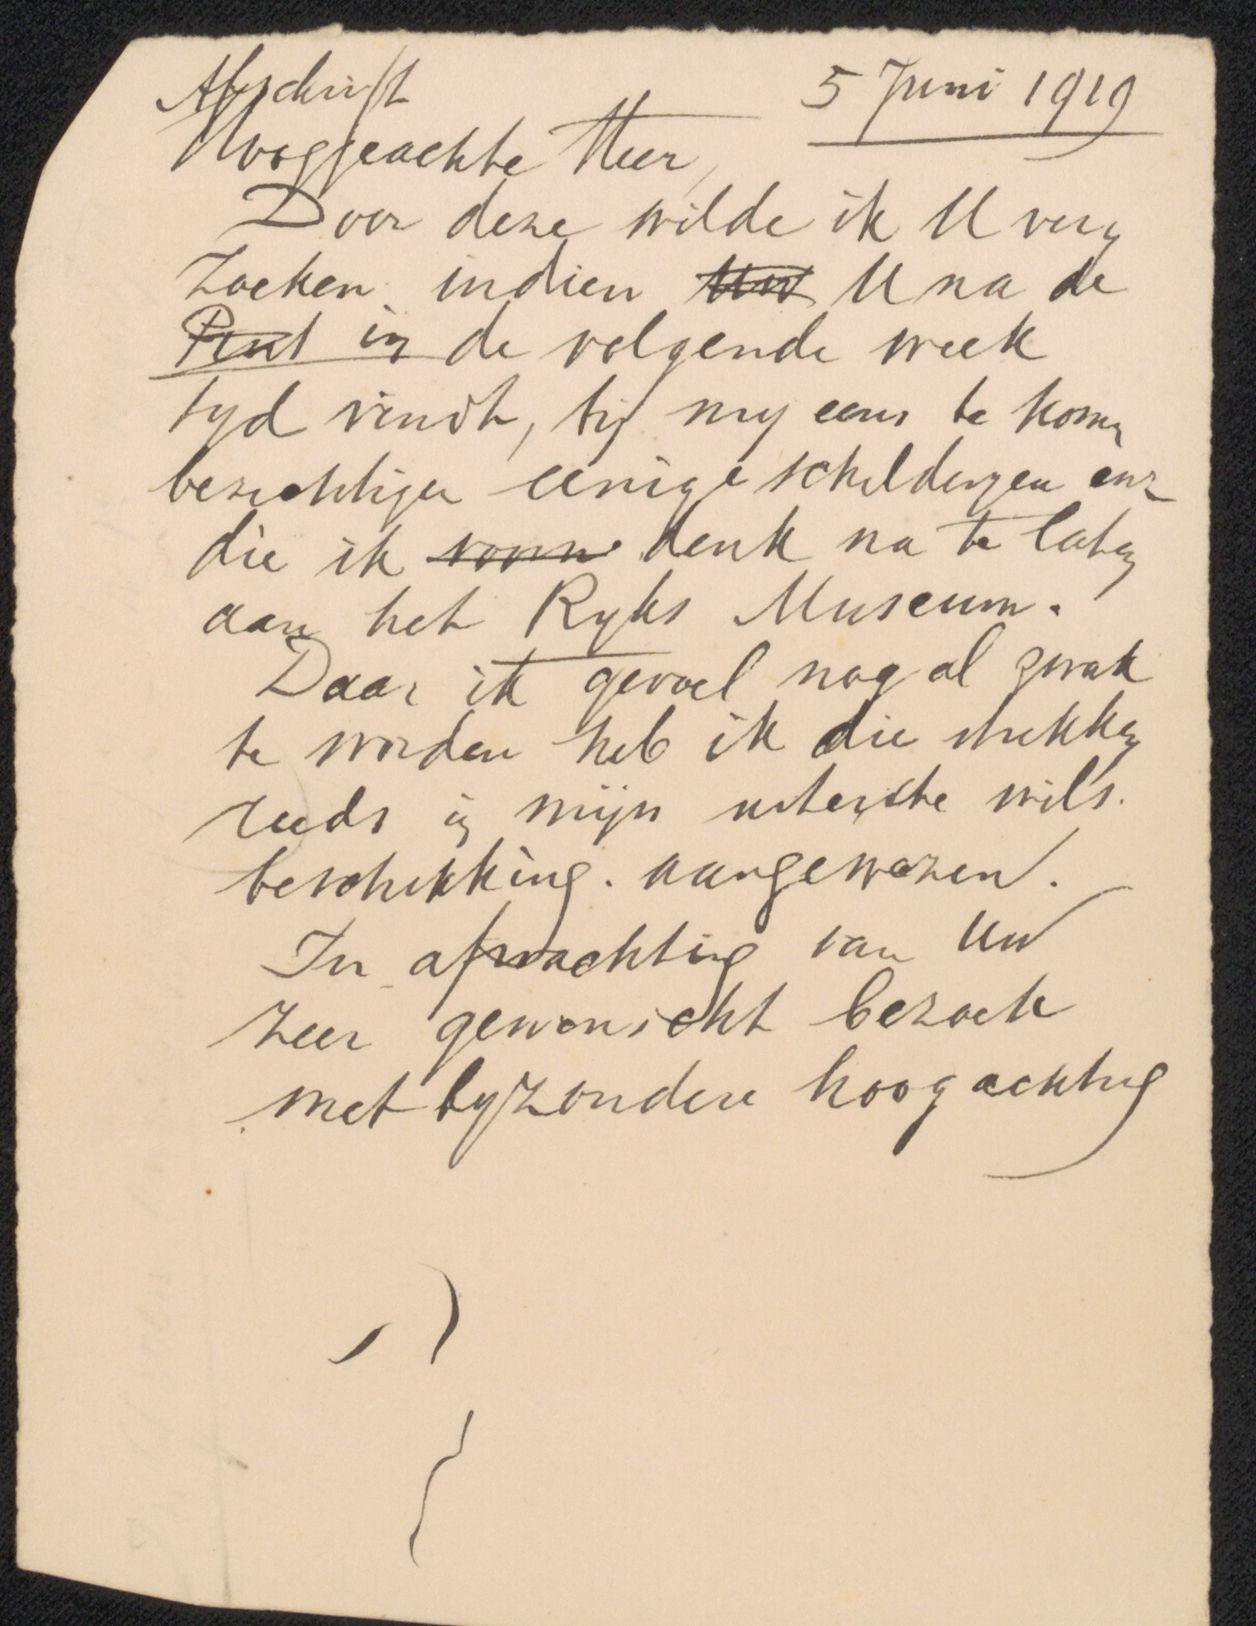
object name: letter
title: Brief aan anoniem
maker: august allebé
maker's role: draughtsman, print maker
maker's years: 1838-1927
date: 1919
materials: cardboard, ink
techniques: pen, writing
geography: amsterdam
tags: rijksmuseum amsterdam, painting (including book-illumination, miniature-painting), art collecting